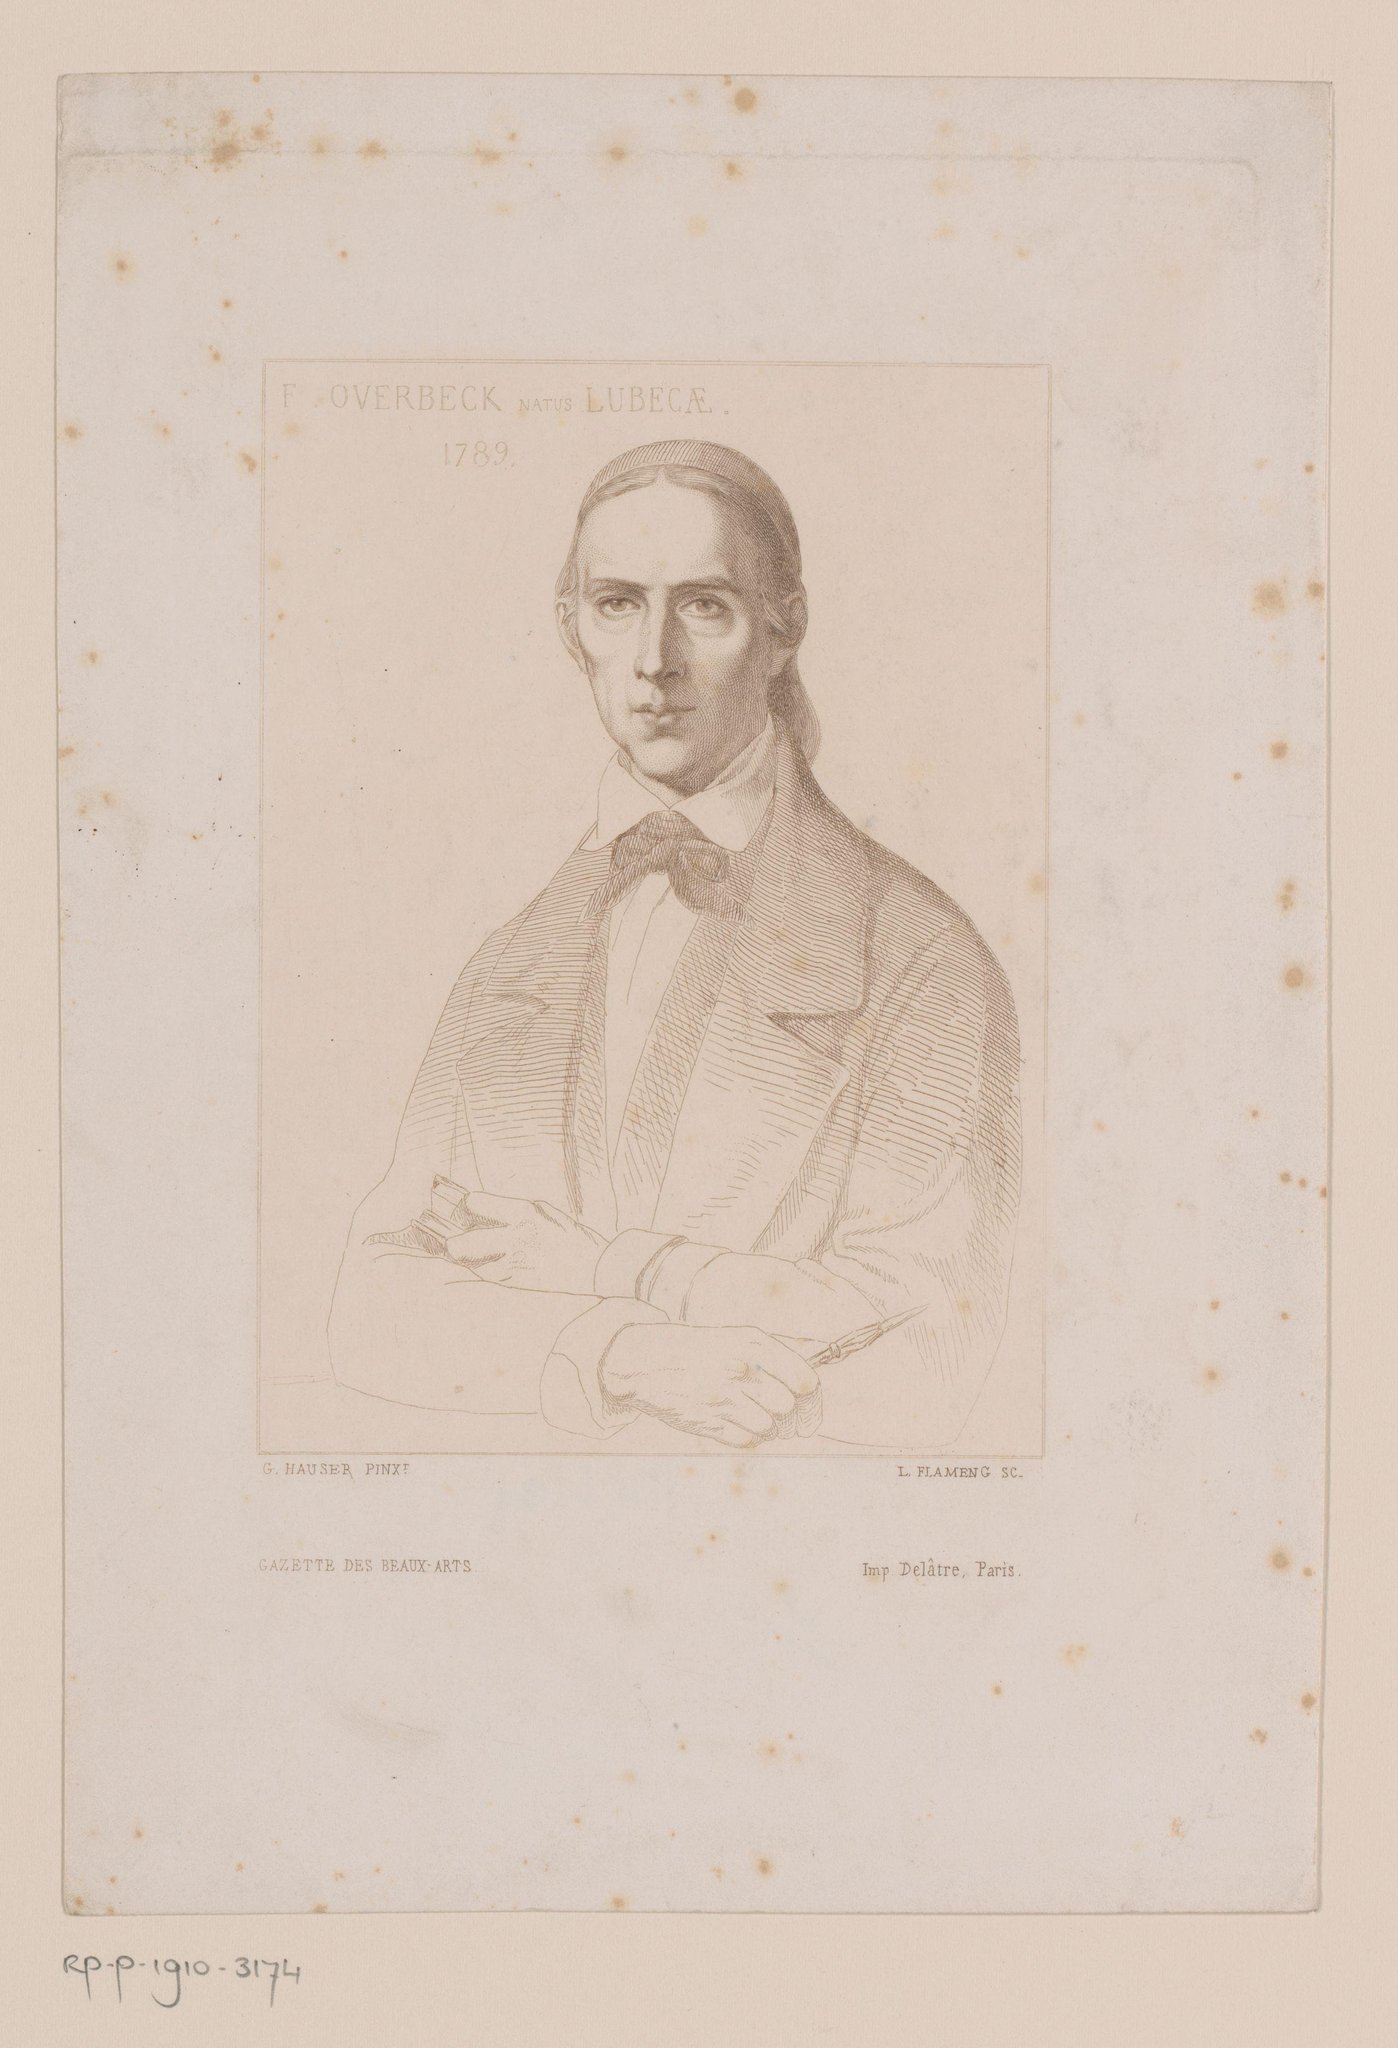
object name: print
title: Portret van Johann Friedrich Overbeck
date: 1860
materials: paper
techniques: etching, intaglio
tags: rome, painter, print maker, johann friedrich overbeck, portrait, self-portrait of painter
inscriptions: collector's mark: Lugt 2228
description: Prent uit: Gazette des beaux-arts (1960), dl. 2, p. 86.